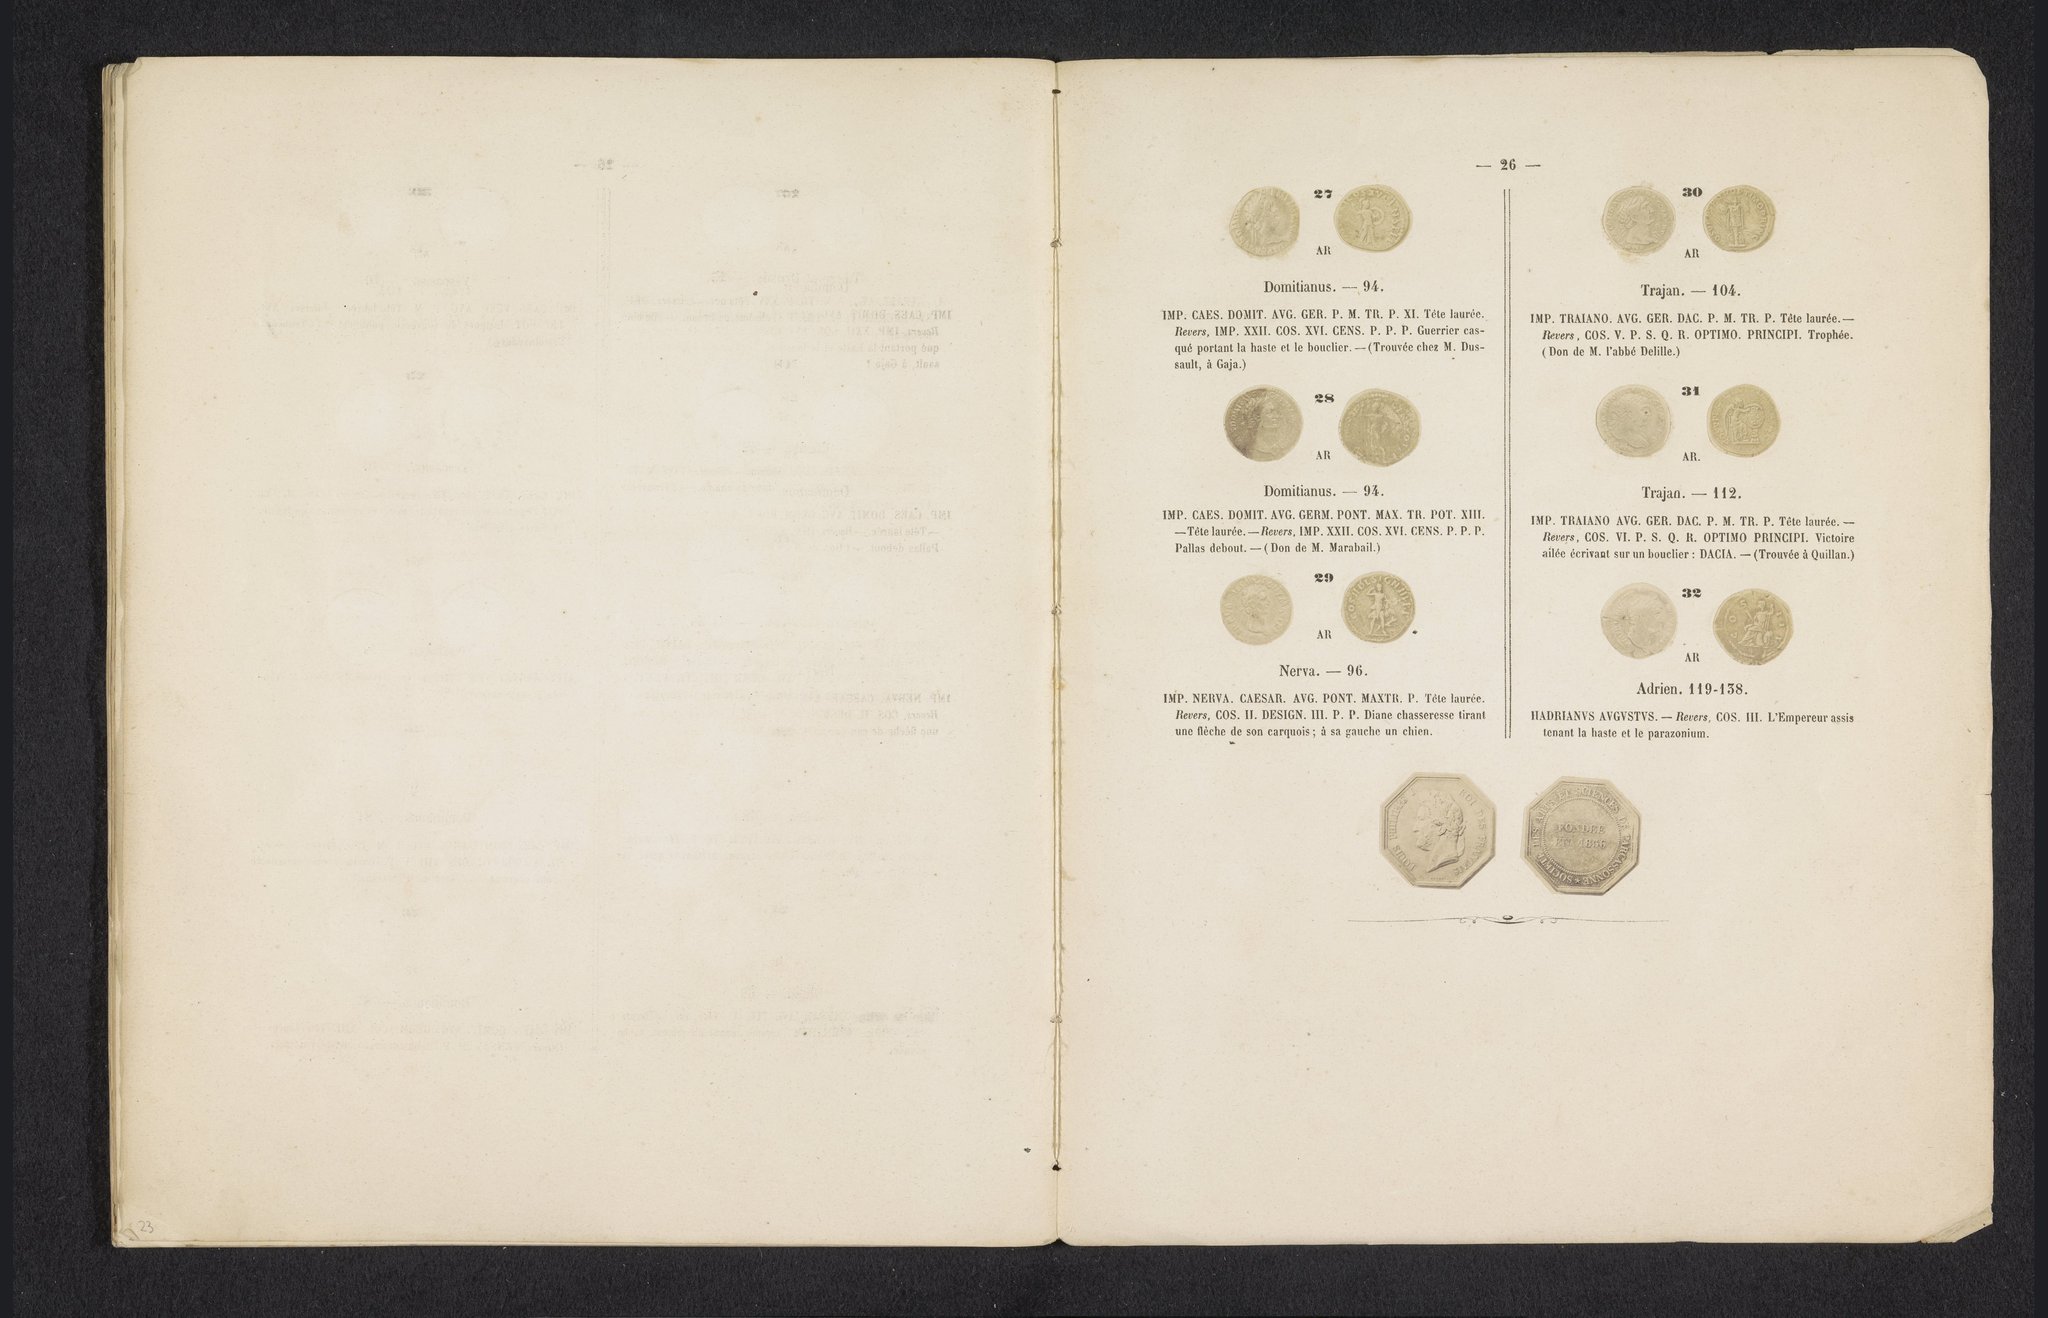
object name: photograph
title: Zeven munten met Romeinse keizers, gezien van voor- en achterkant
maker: léopold verguet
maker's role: abt, fotograaf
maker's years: 1817-1914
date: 1854-1864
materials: photographic support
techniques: albumen print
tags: rome, coin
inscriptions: number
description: Nummers 27 tot en met 32: Domitianus, Domitianus, Nerva, Trajanus en vermoedelijk Hadrianus.